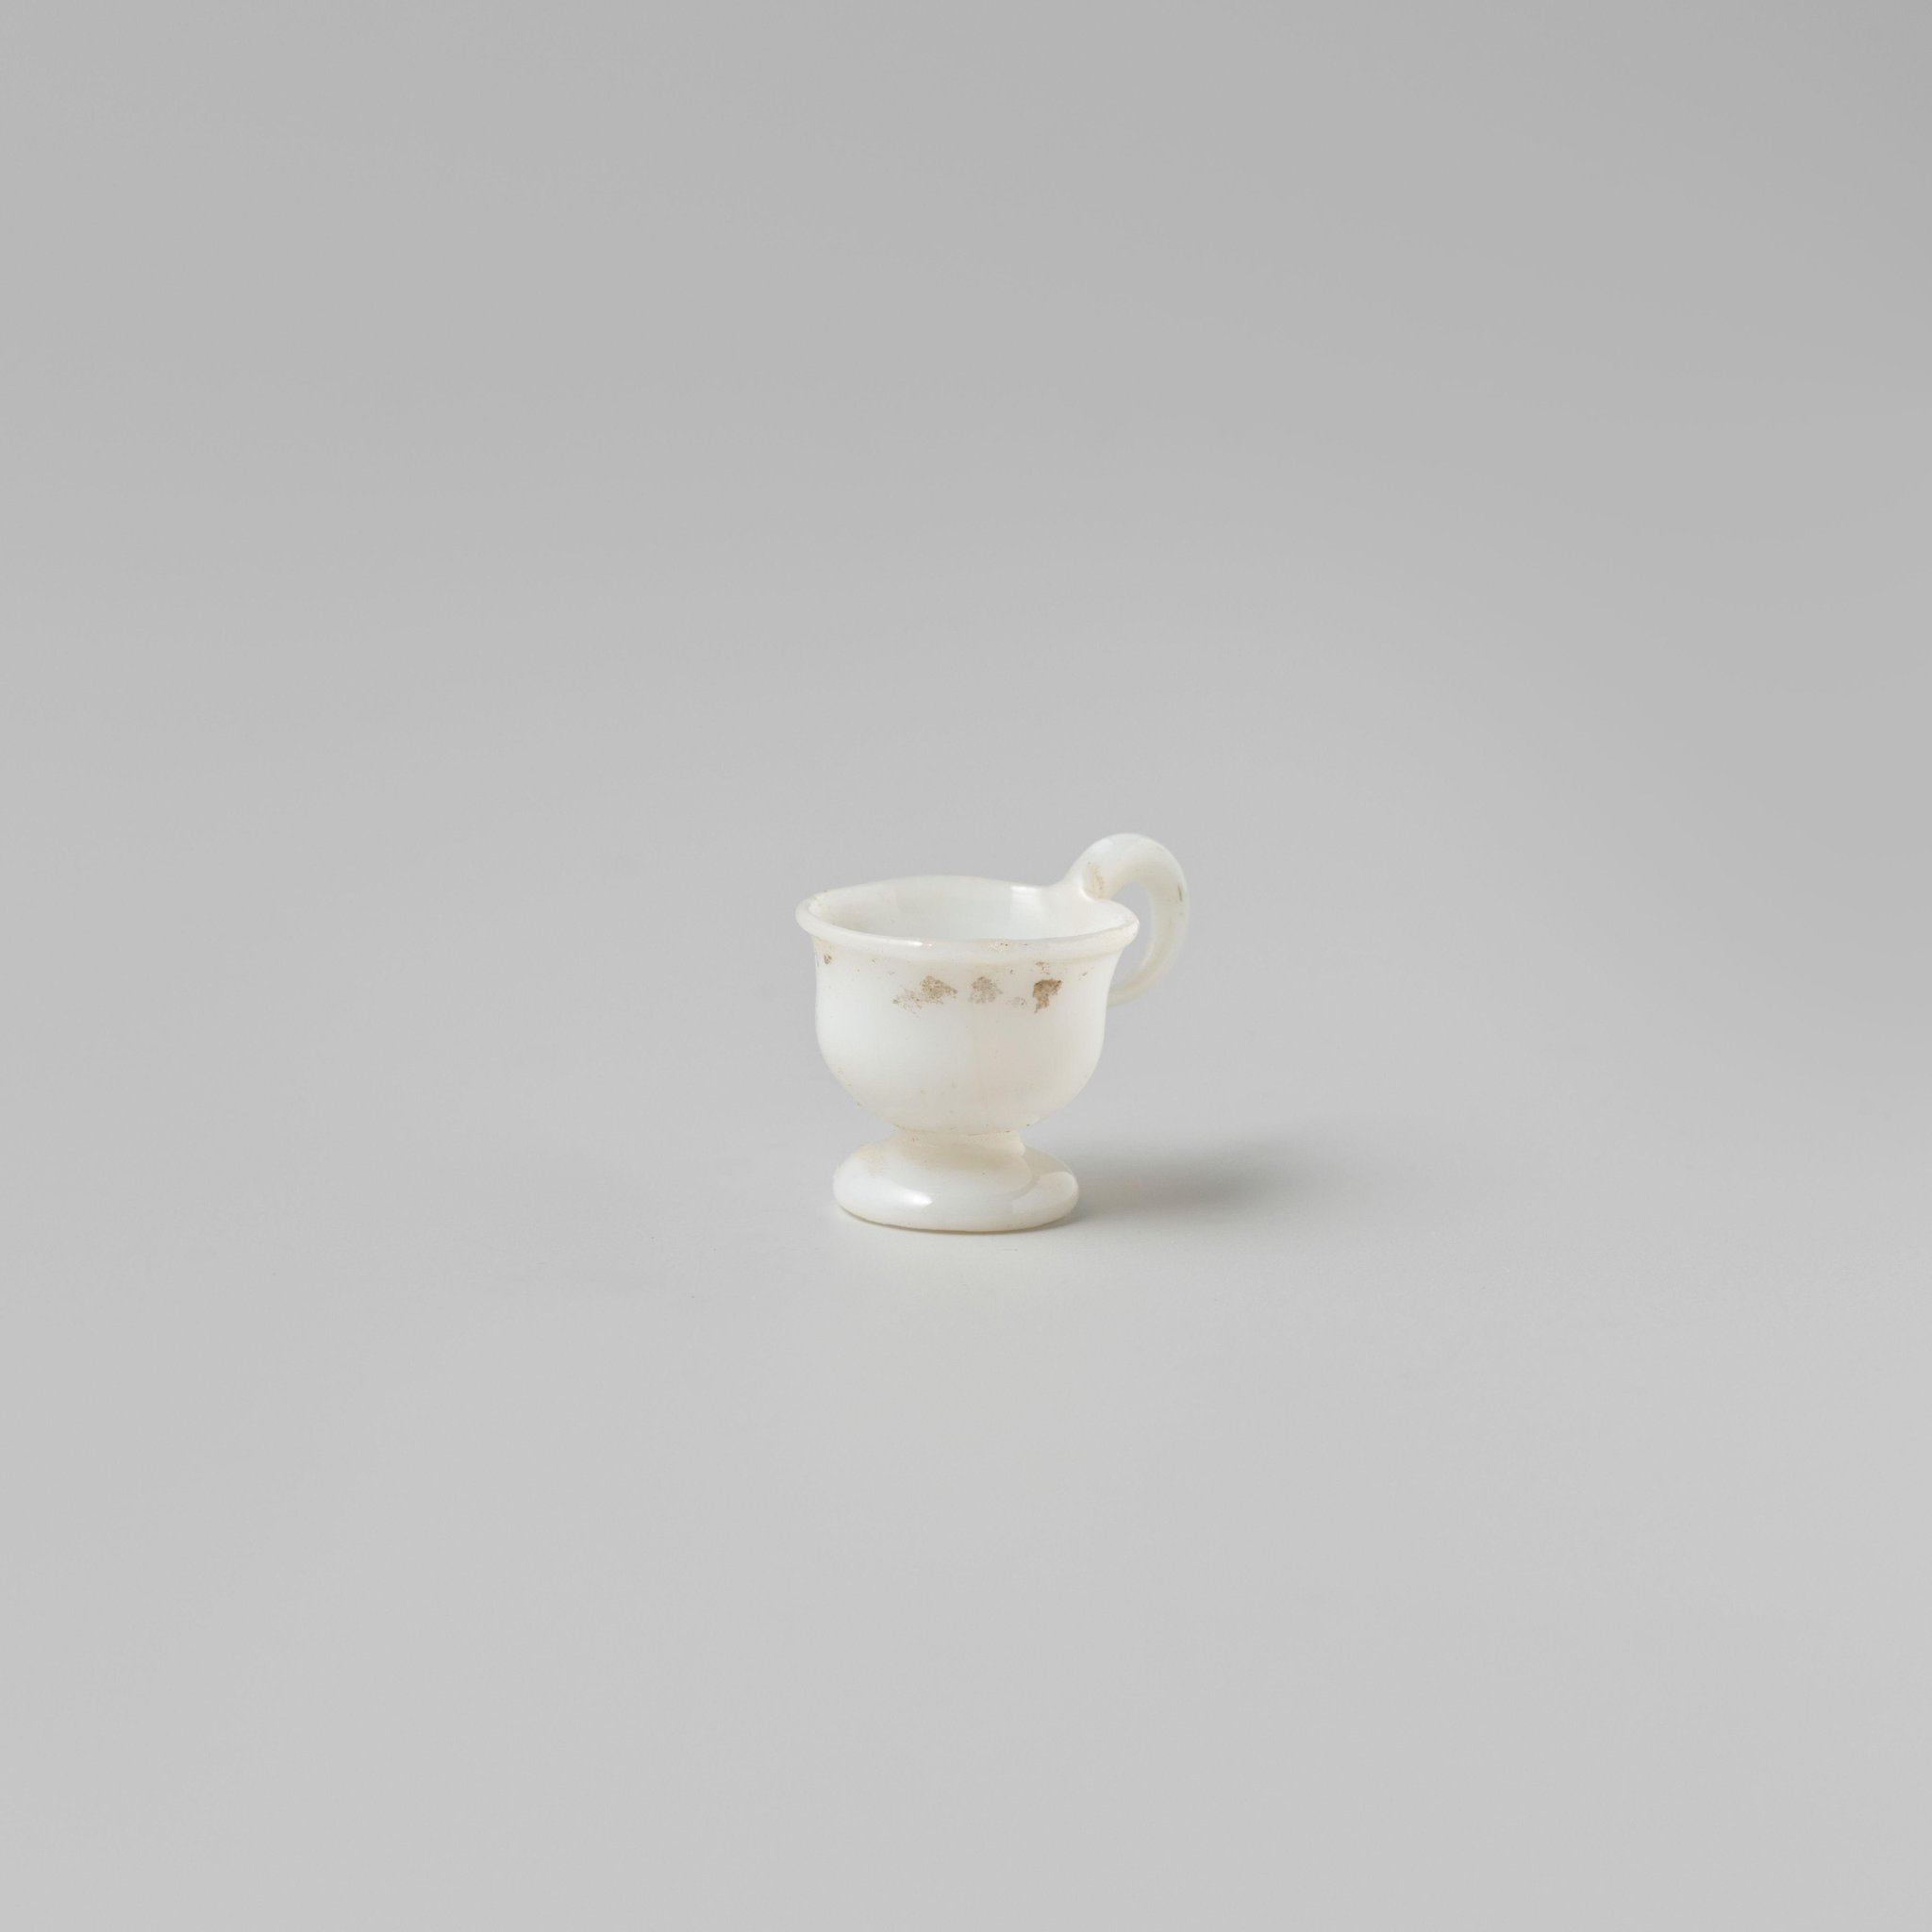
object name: miniature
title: Kop met oor, beschilderd met bloem in wit, rood en groen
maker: Anonymous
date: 1800-1849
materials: glass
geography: bristol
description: Kop van opaak wit glas, bol model op voet, met s-vormig oor. De kop is beschilderd met een bloem in wit, rood en groen.